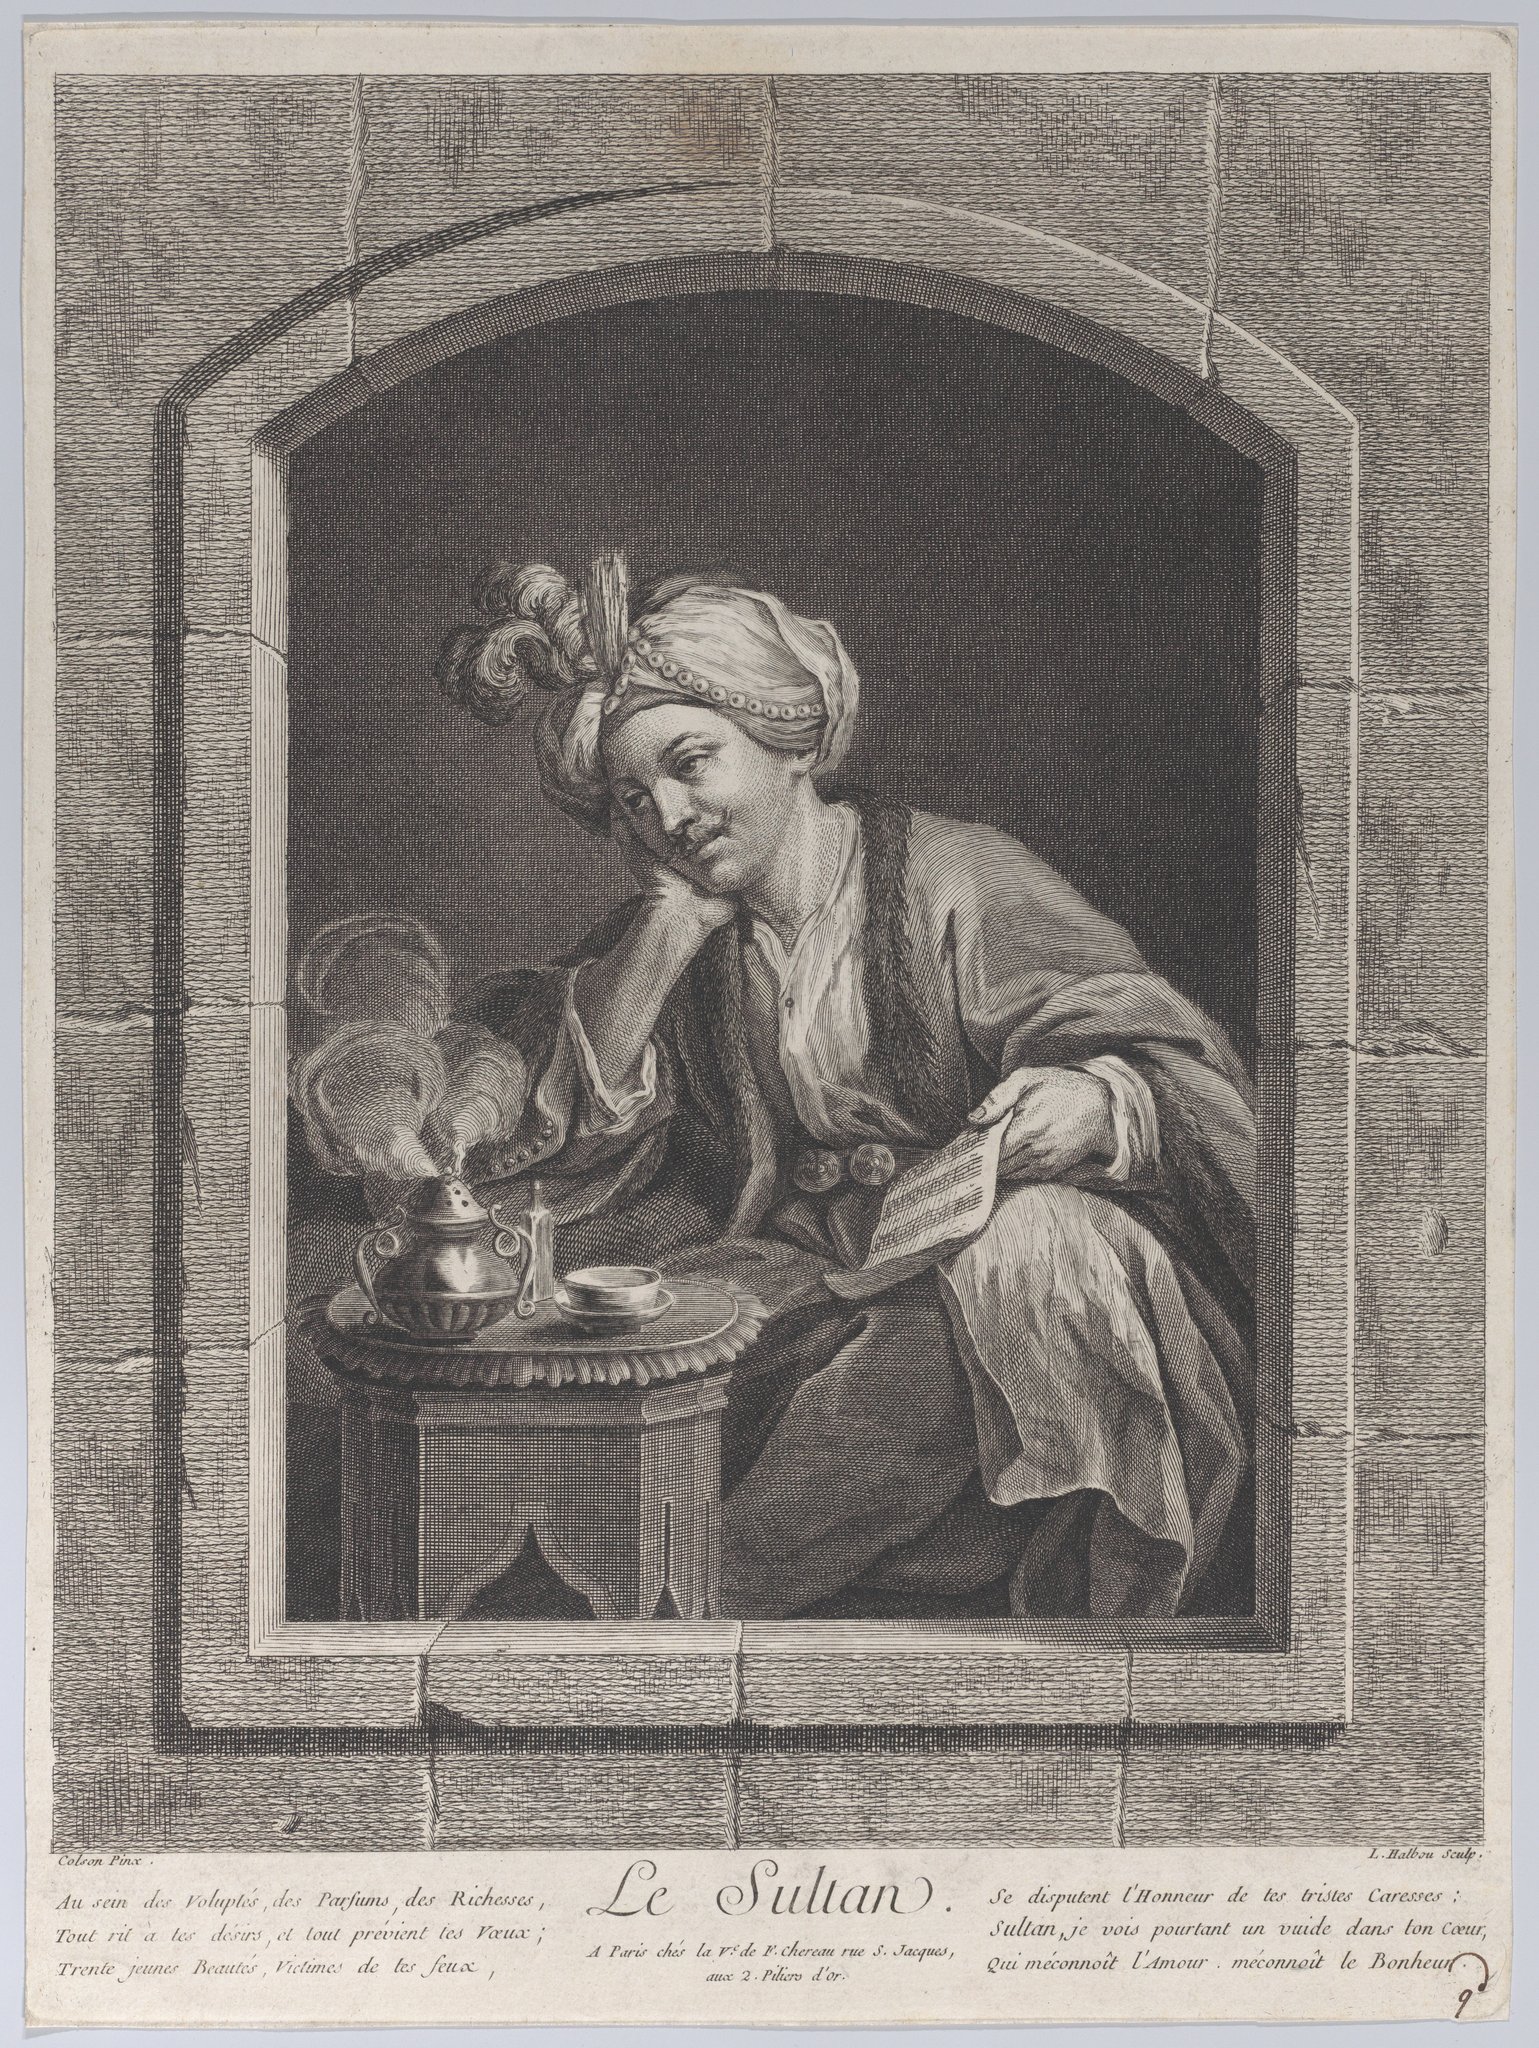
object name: print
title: Le Sultan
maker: louis michel halbou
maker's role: artist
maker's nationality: french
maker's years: 1730-1809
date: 1760-1790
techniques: engraving, etching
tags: men